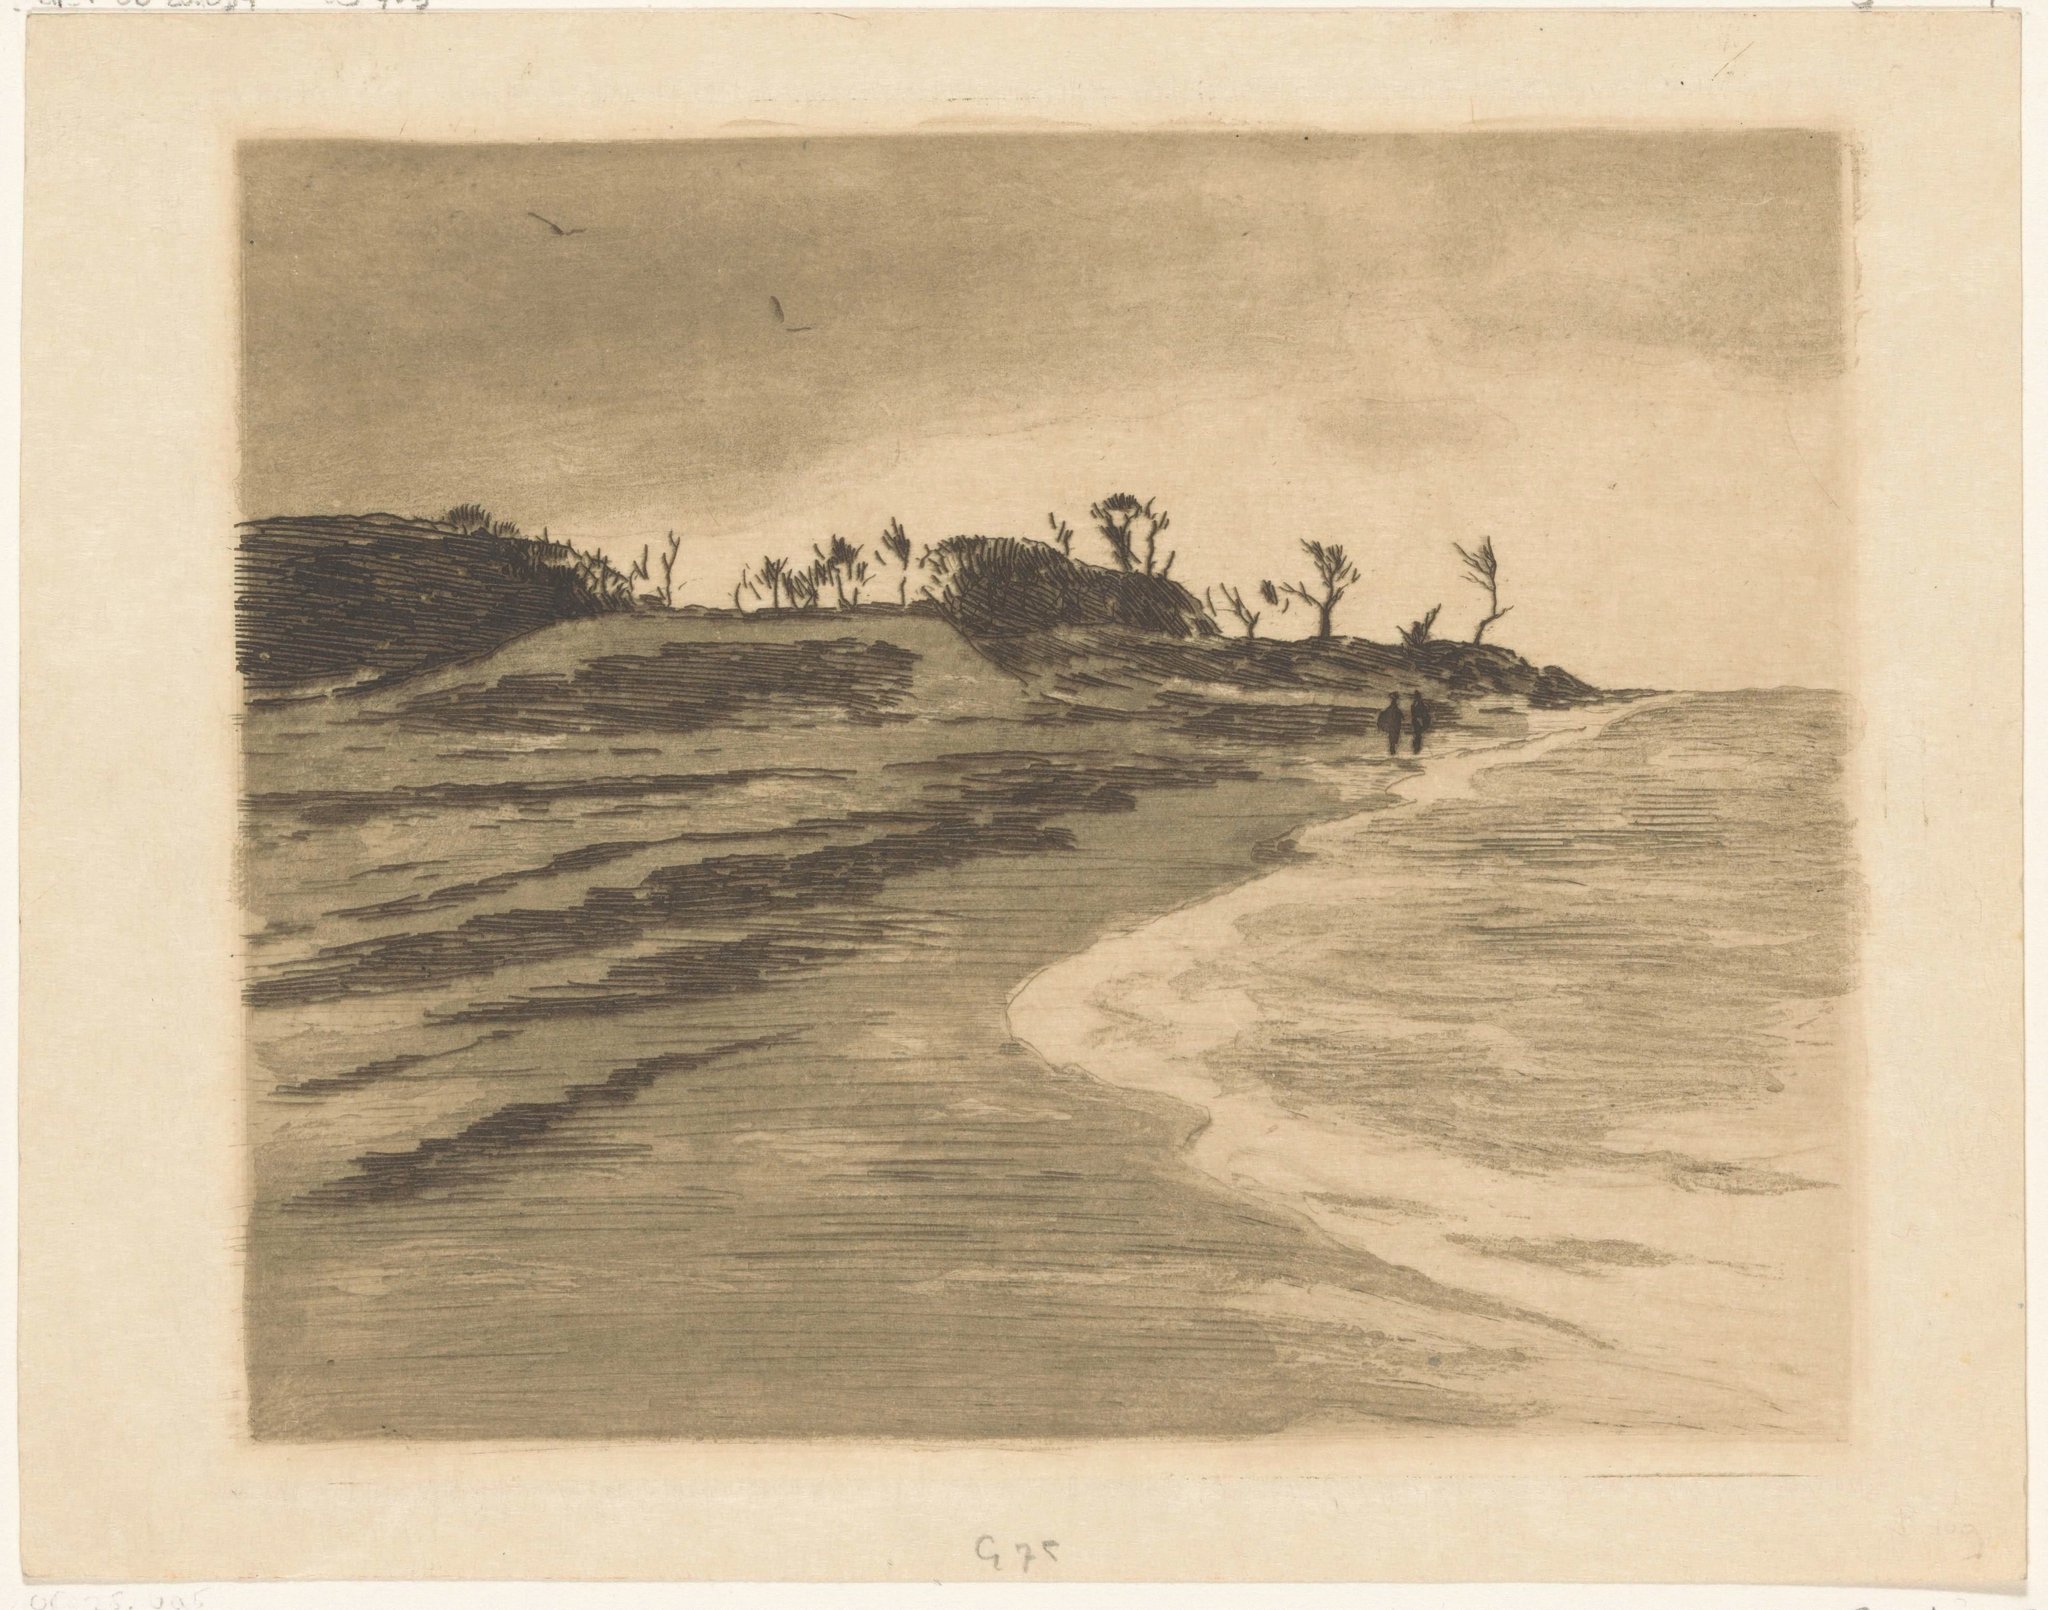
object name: print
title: Kustlijn van de Zuiderzee in Valkeveen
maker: willem witsen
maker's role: draughtsman, painter, print maker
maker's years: 1860-1923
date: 1913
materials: paper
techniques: aquatint, etching, intaglio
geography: amsterdam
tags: walking, hiking (recreation), coast, zuiderzee